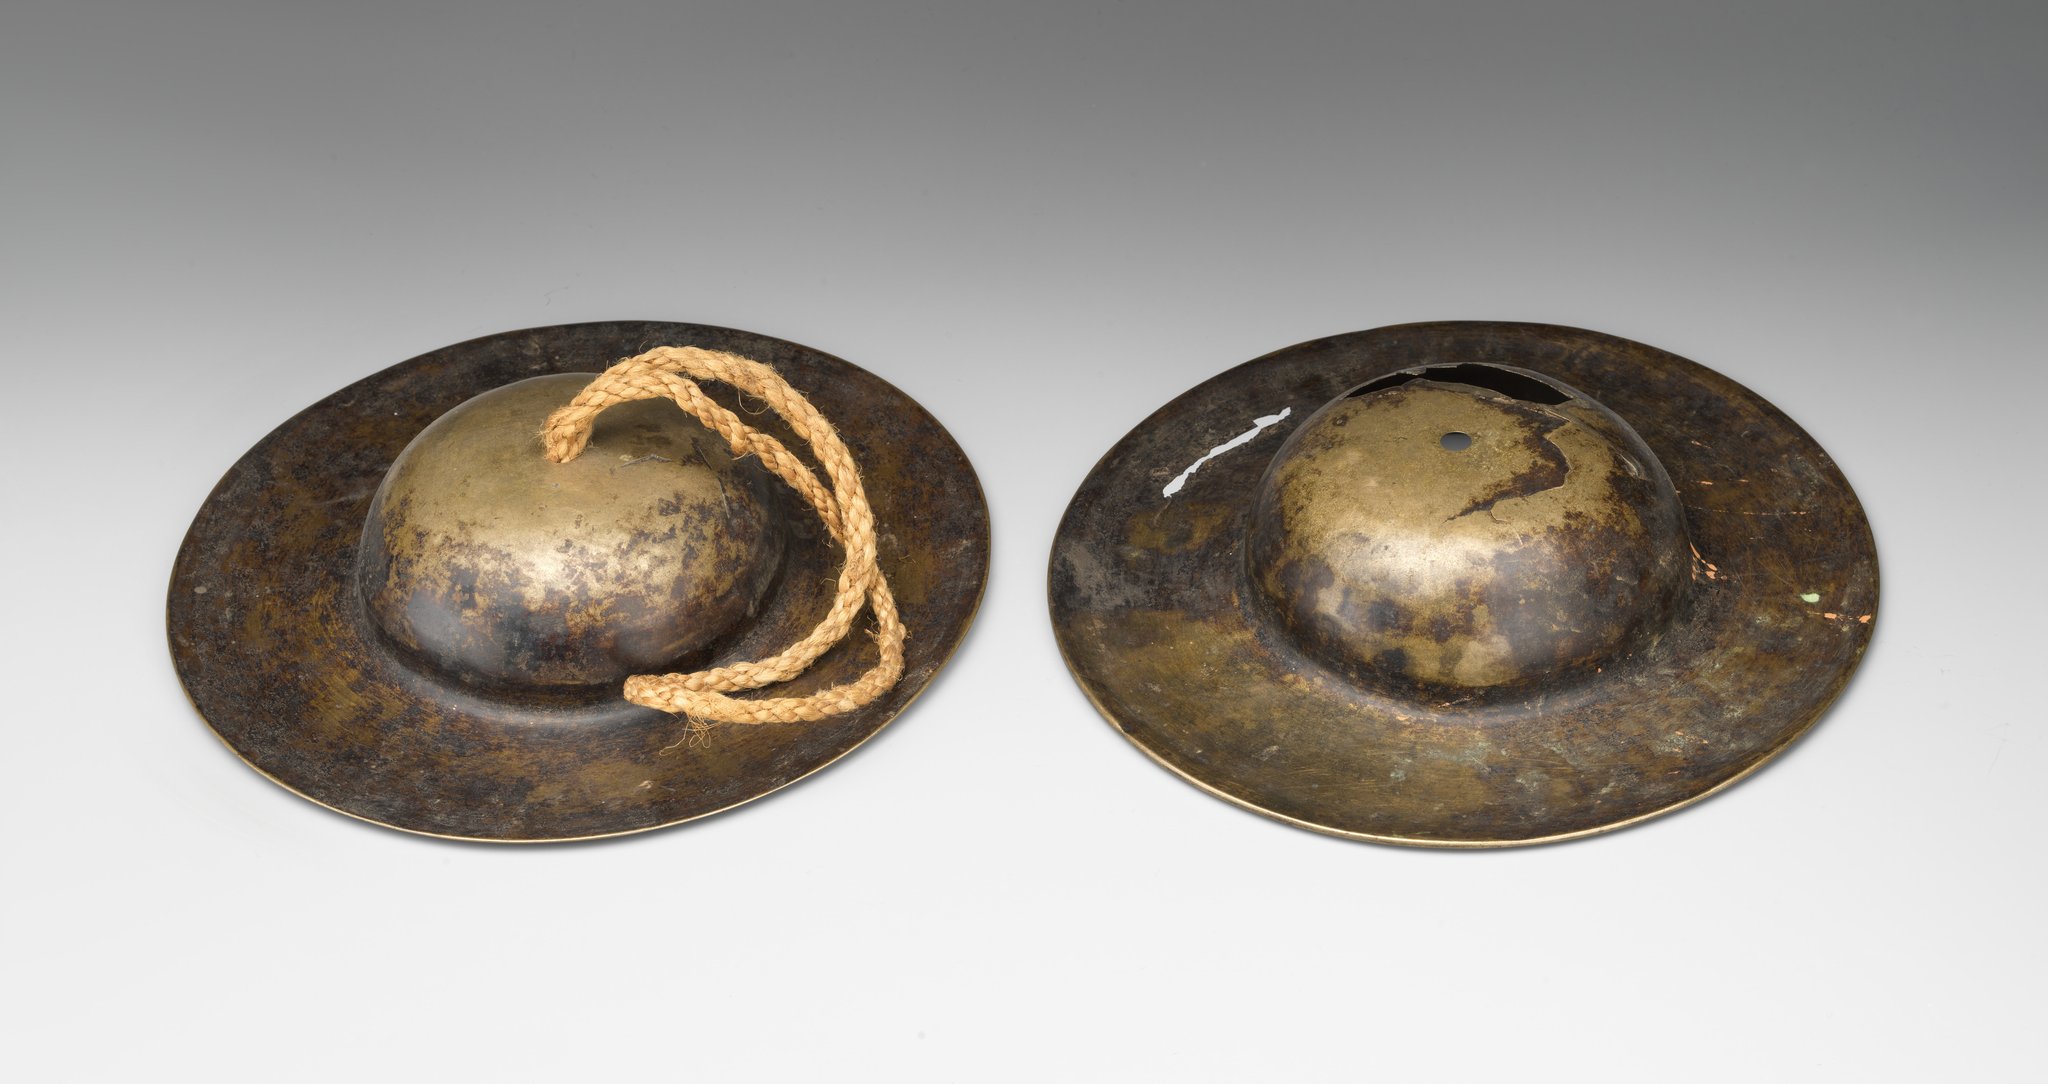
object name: jhyālī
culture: nepalese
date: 1801-1900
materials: brass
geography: nepal